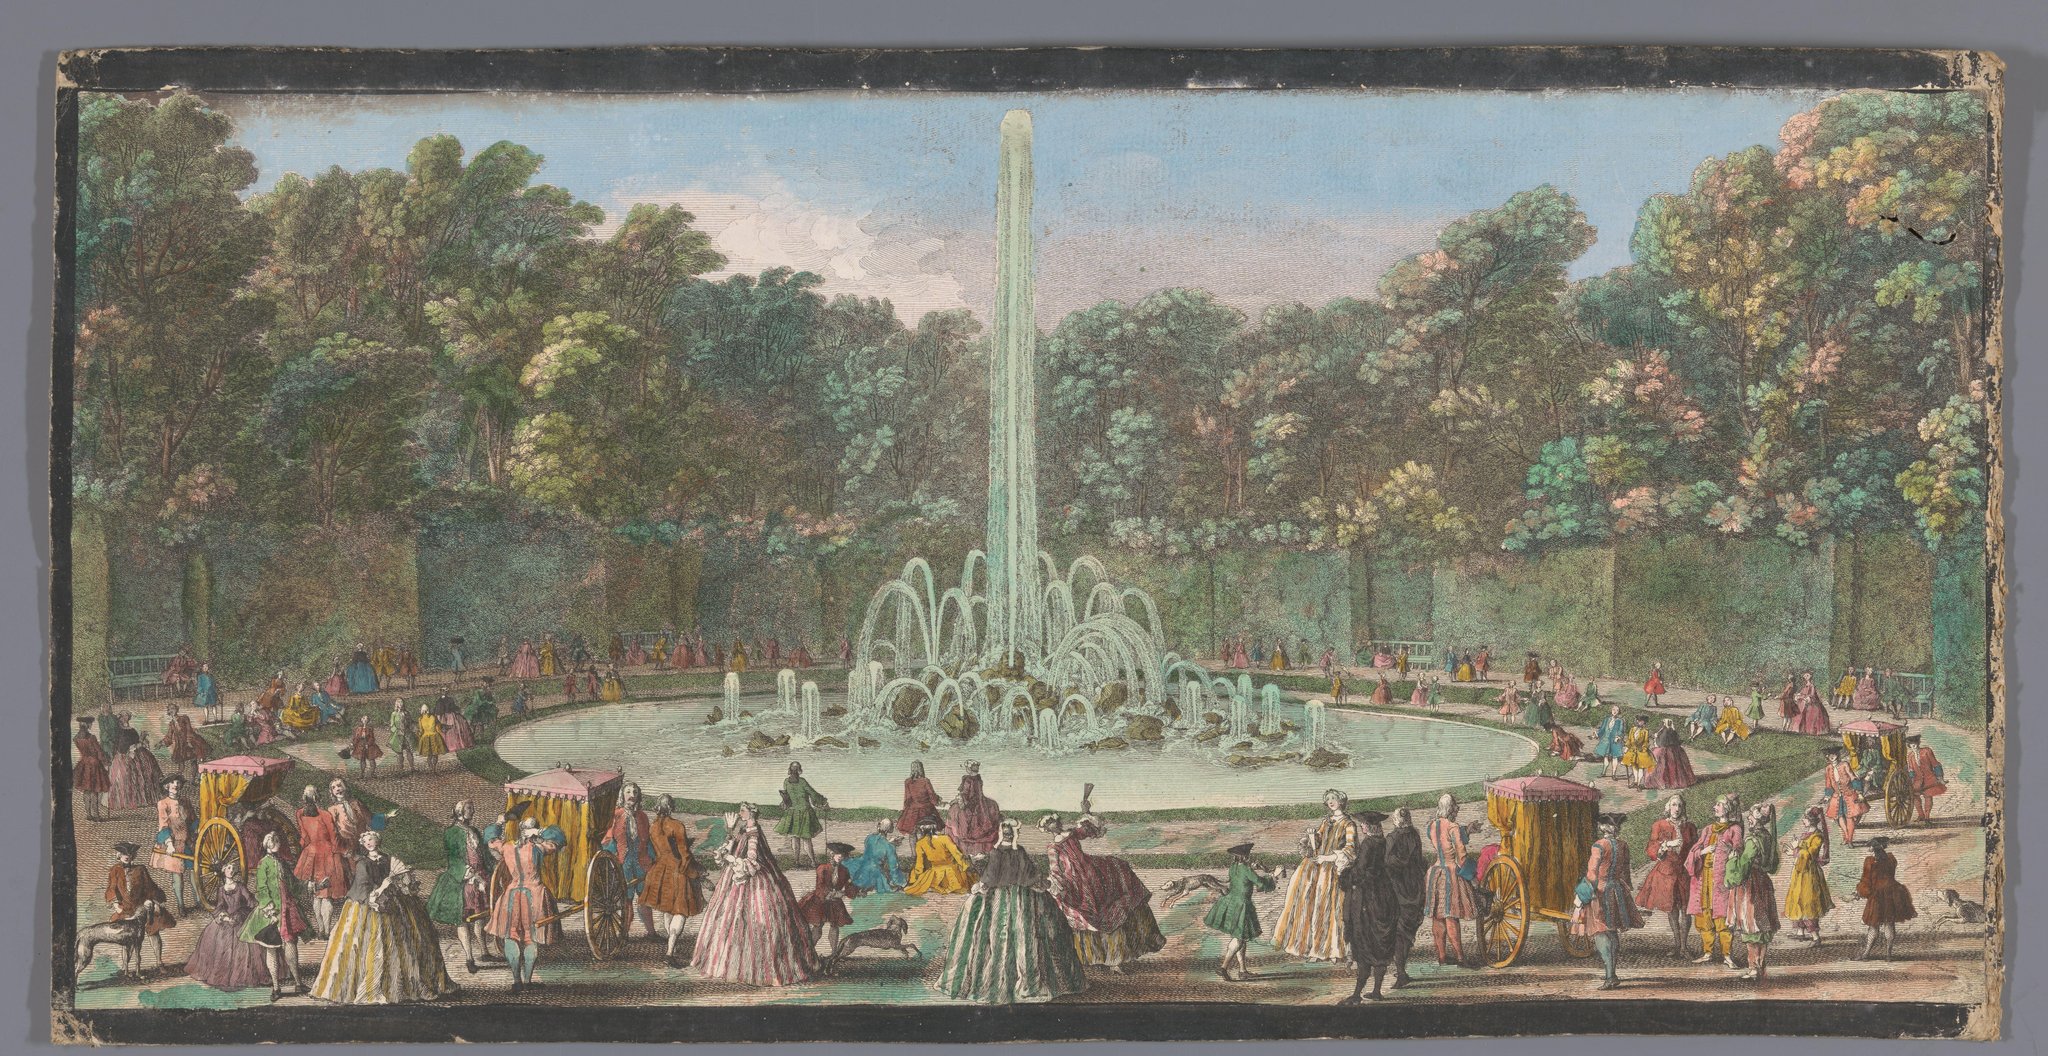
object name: opticaprent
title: Le Bassin d'Encelade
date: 1700-1799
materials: cardboard, paper, watercolor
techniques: brush, etching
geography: paris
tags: garden, garden fountain, ornamental plants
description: In de ondermarge twee regels Franse tekst.